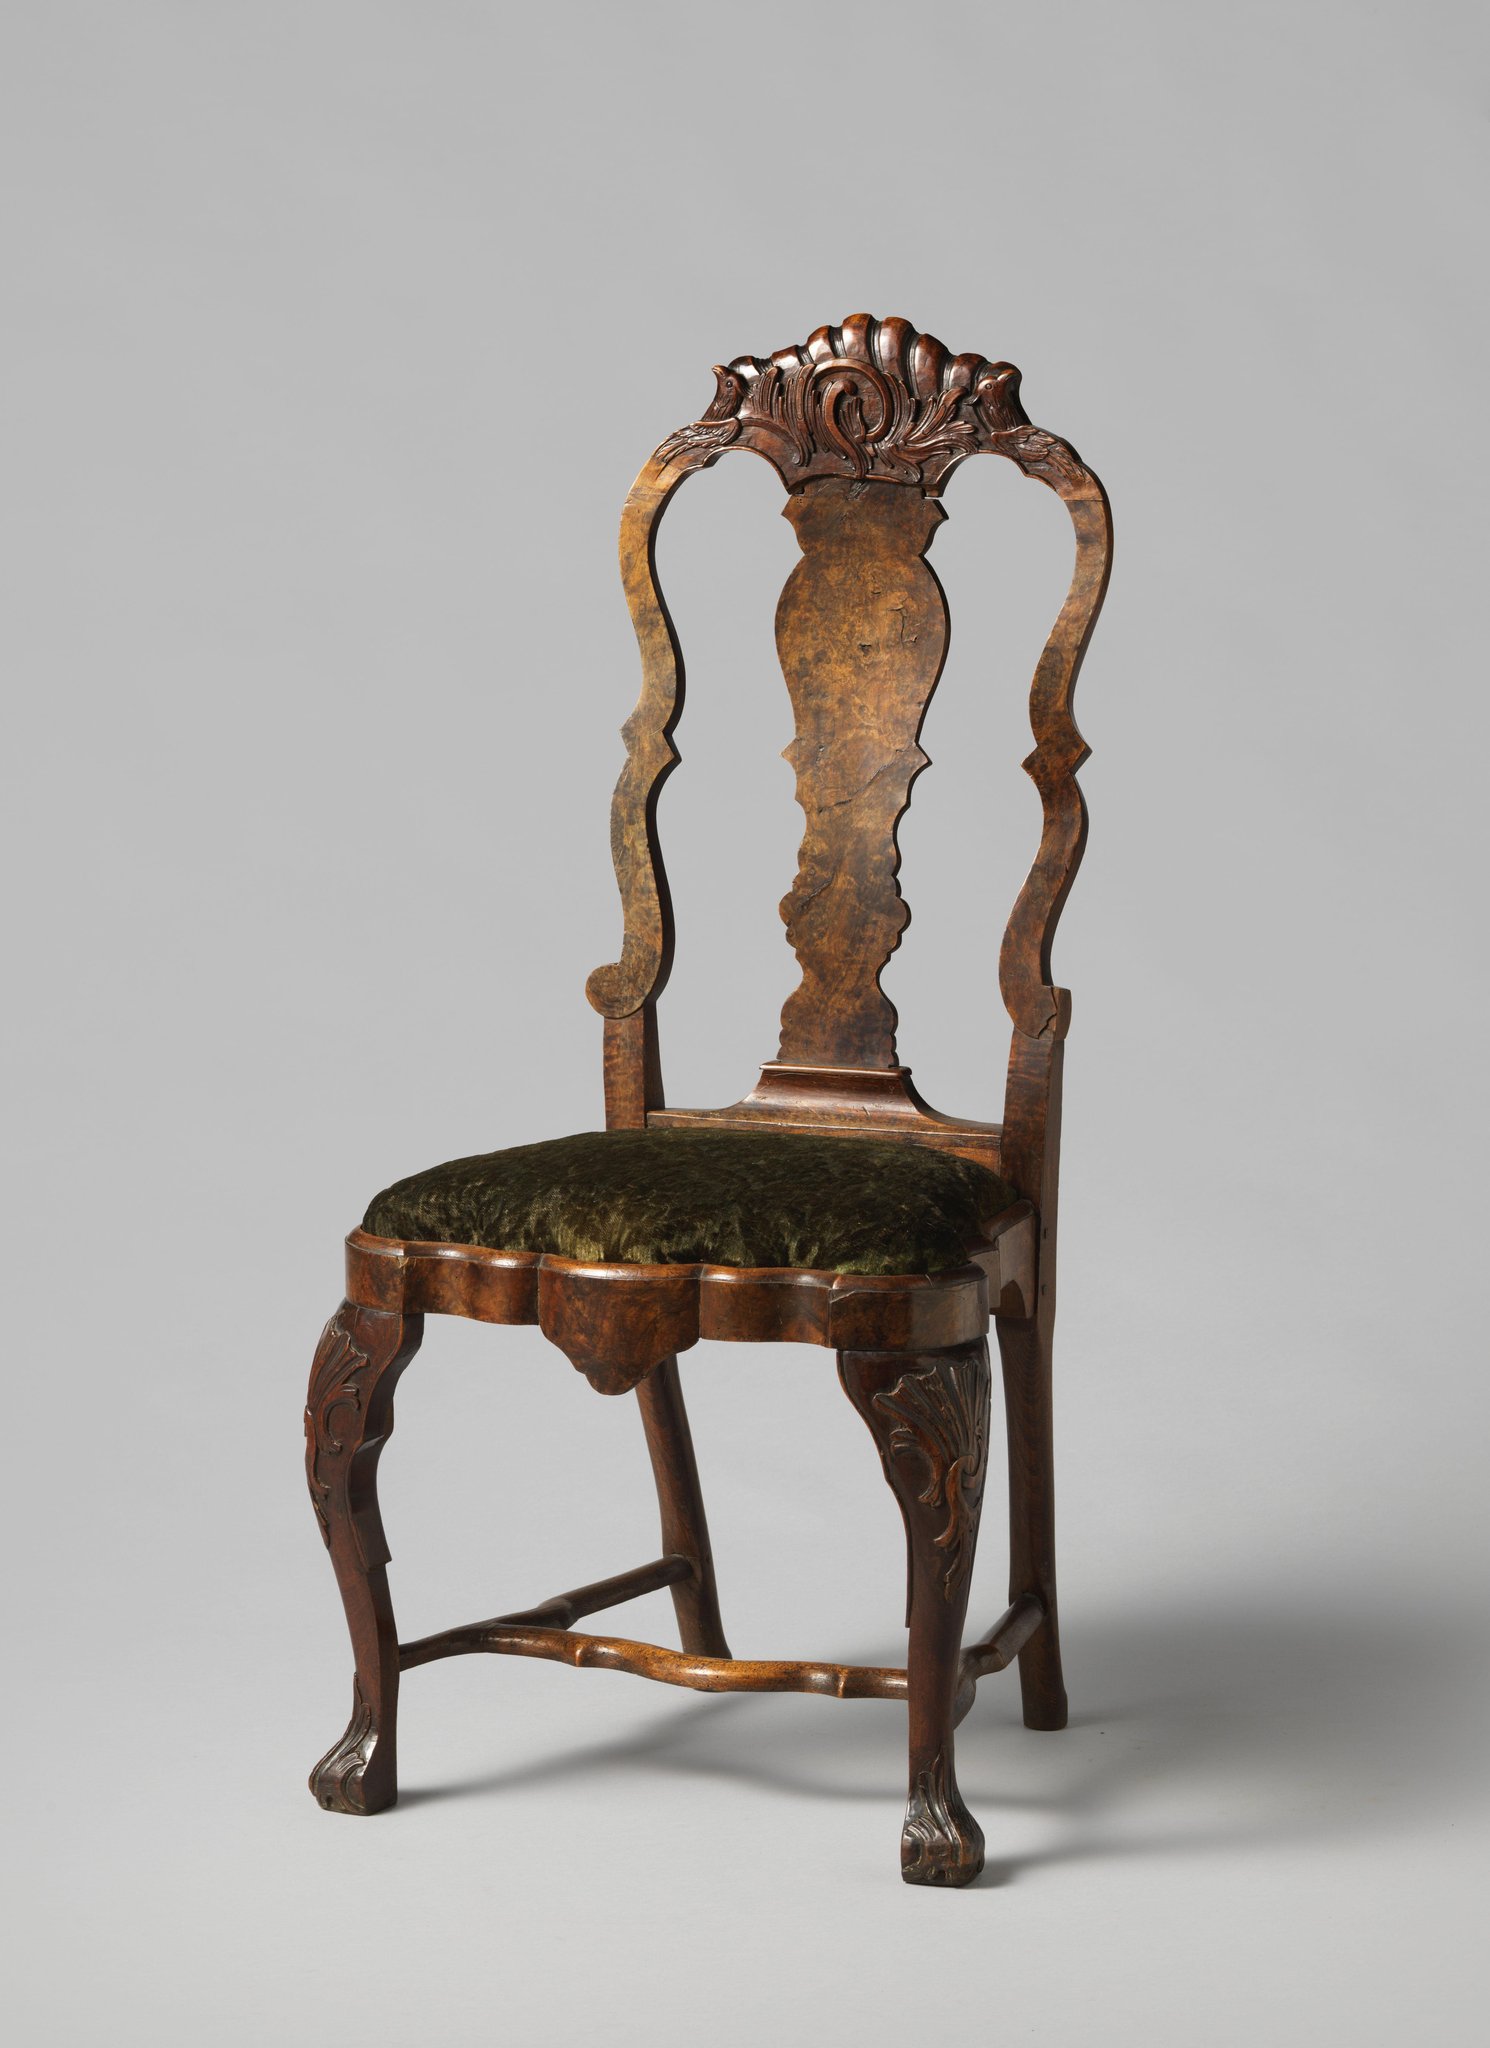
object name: chair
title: Meubilair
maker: Anonymous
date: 1700-1750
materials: wood, velvet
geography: netherlands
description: Stoel van iepenhout, de voorpoten en de kop van notenhout, de rug en het zitraam belijmd met wortelnotenhout. De overhoeks geplaatste S-vormige voorpoten zijn versierd met rocaille-motieven. Het H-vormige kruis is geschulpt. Het geschulpte zitraam heeft een los groenfluwelen kussen met een patroon van bladeren en bloemen. De horizontaal geholde rug heeft een symmetrisch uitgezaagde middenbaan, hoekstijlen in de vorm van S-voluten en een bovendorpel versierd met rocaille-motieven en vogelkoppen.